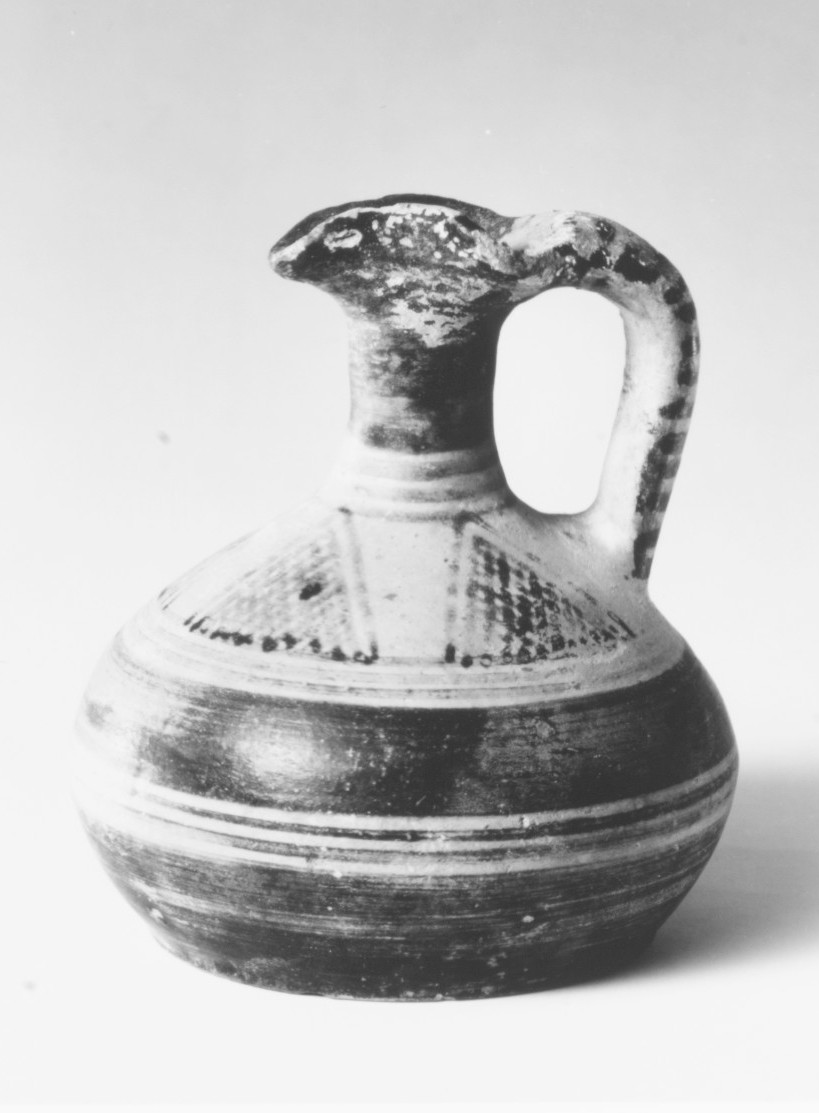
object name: oinochoe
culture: greek, attic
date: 800-701 BCE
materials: terracotta